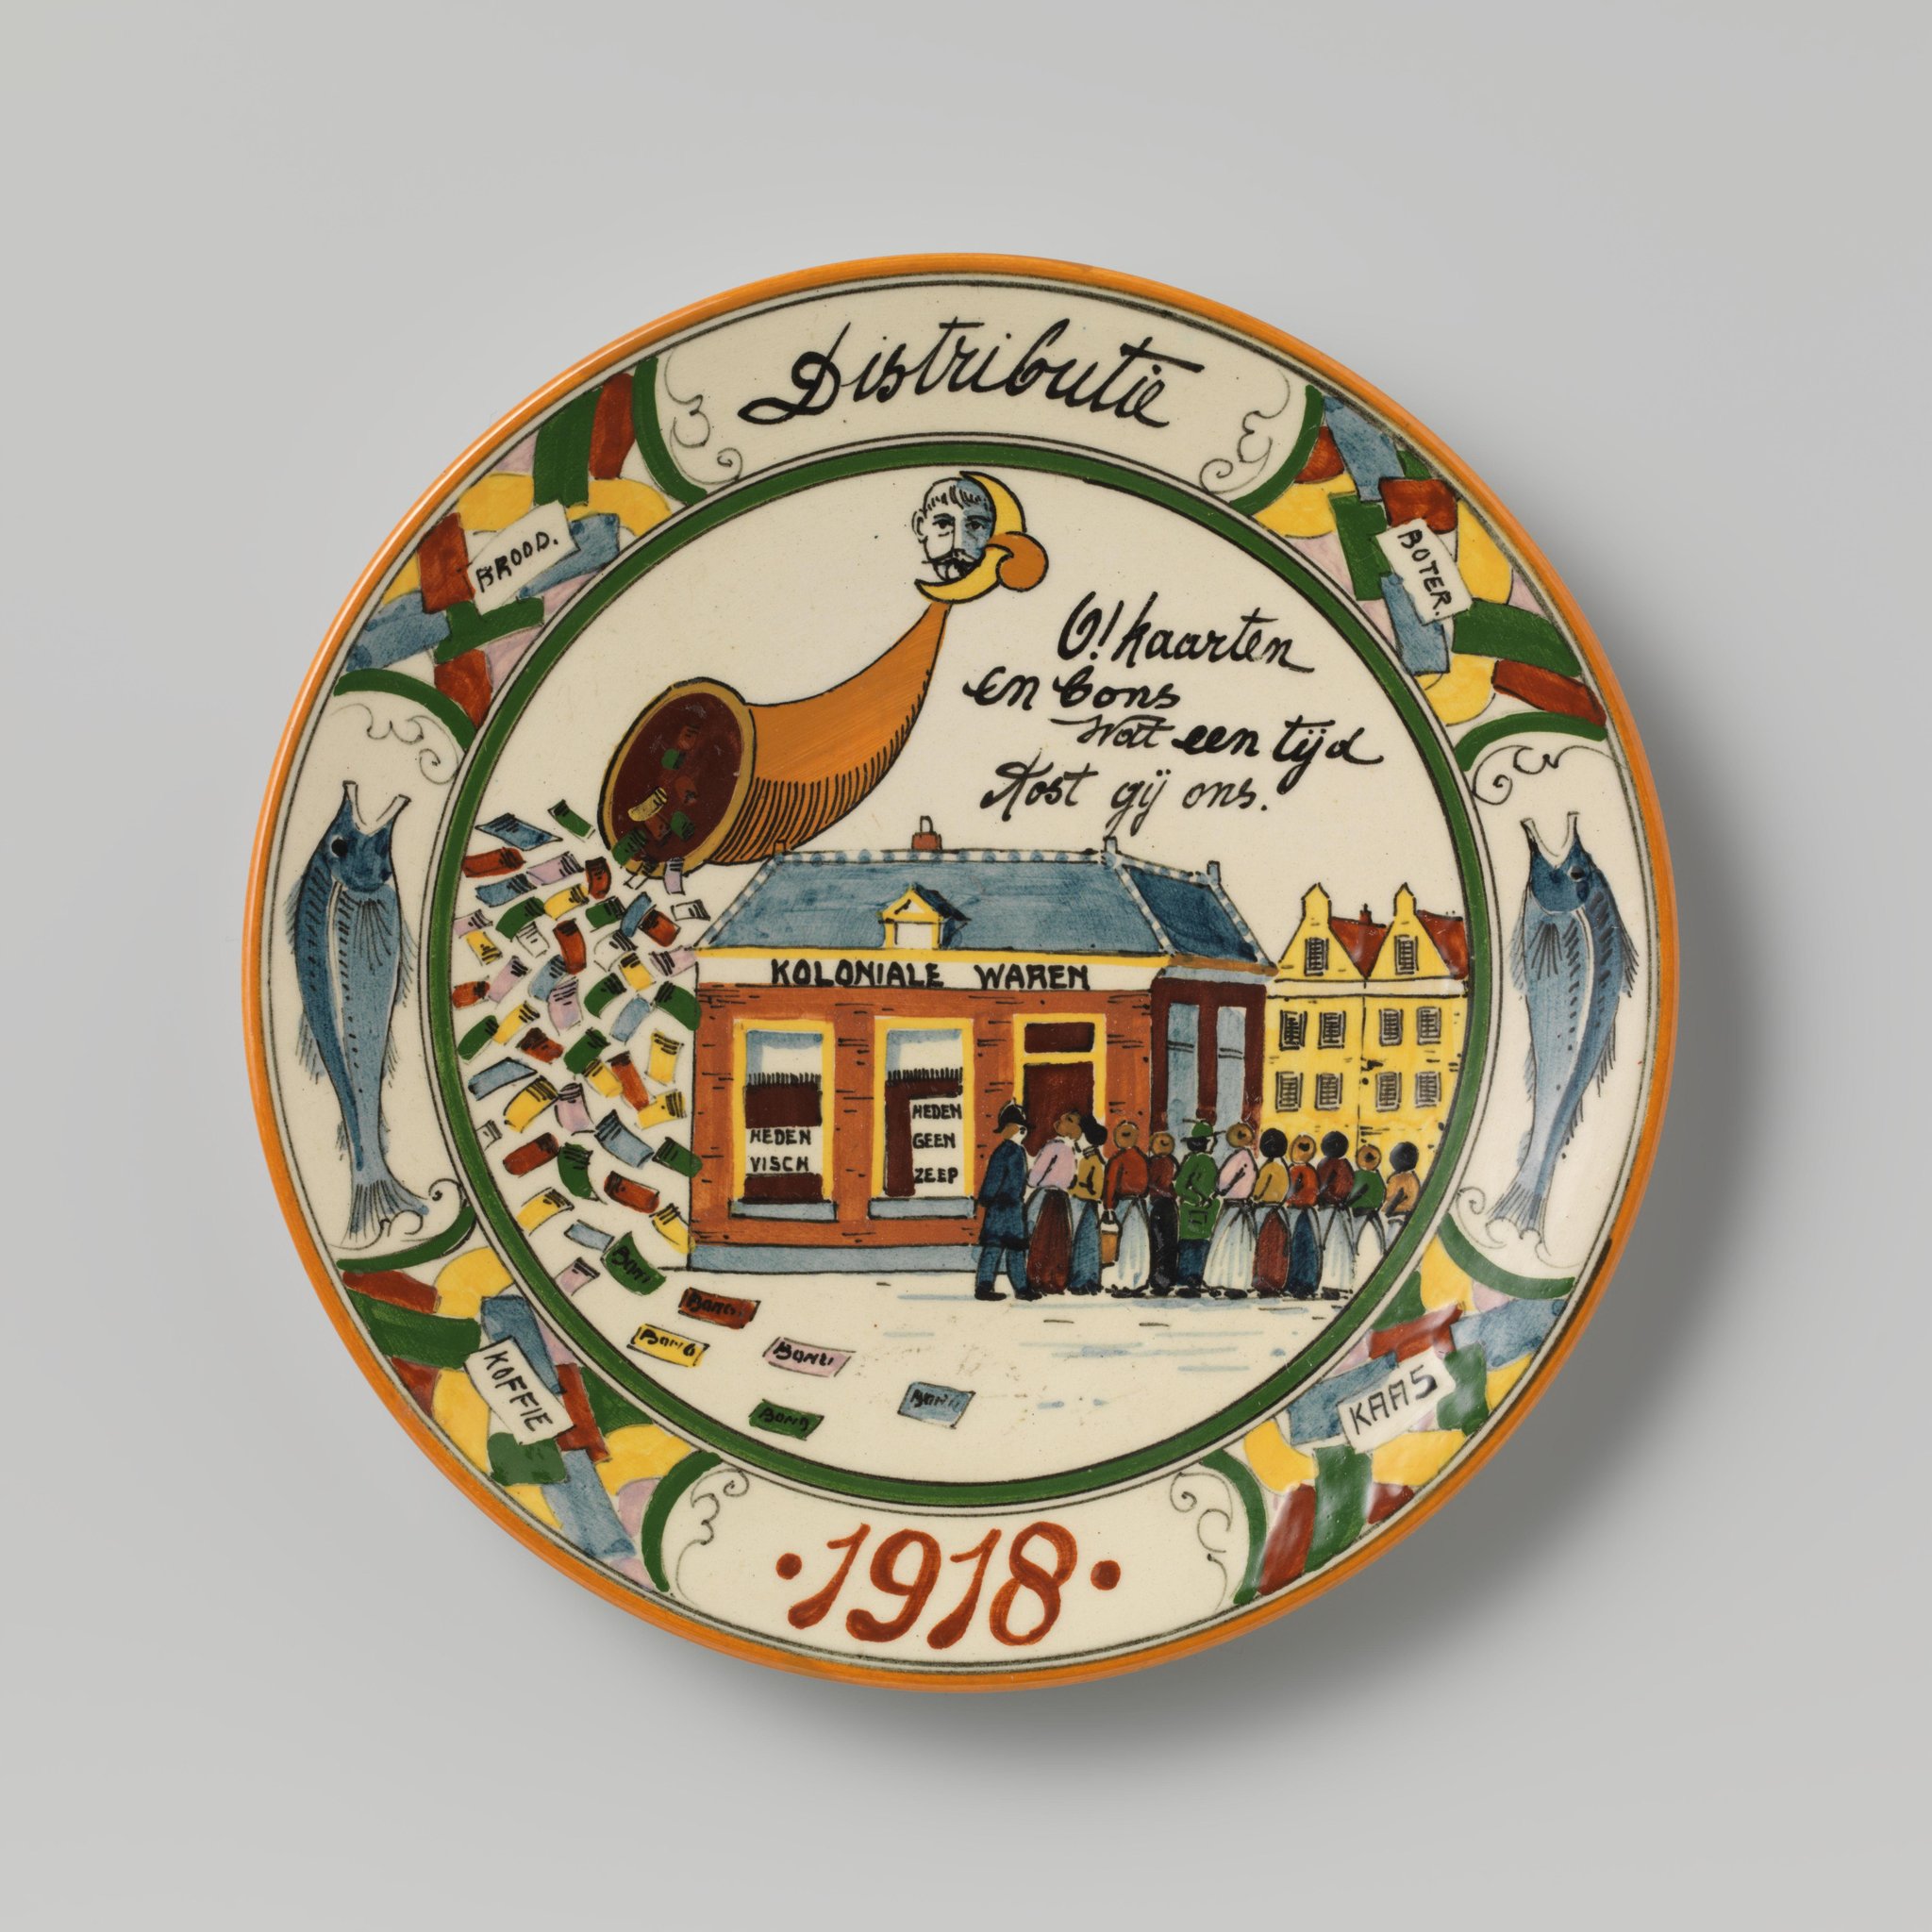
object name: plate dish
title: Herdenkingsbord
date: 1918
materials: earthenware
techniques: firing, painted, vitrification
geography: enschede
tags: netherlands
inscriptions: inscription: ‘Distributie O! kaarten en bons Wat een tijd kost gij ons.’